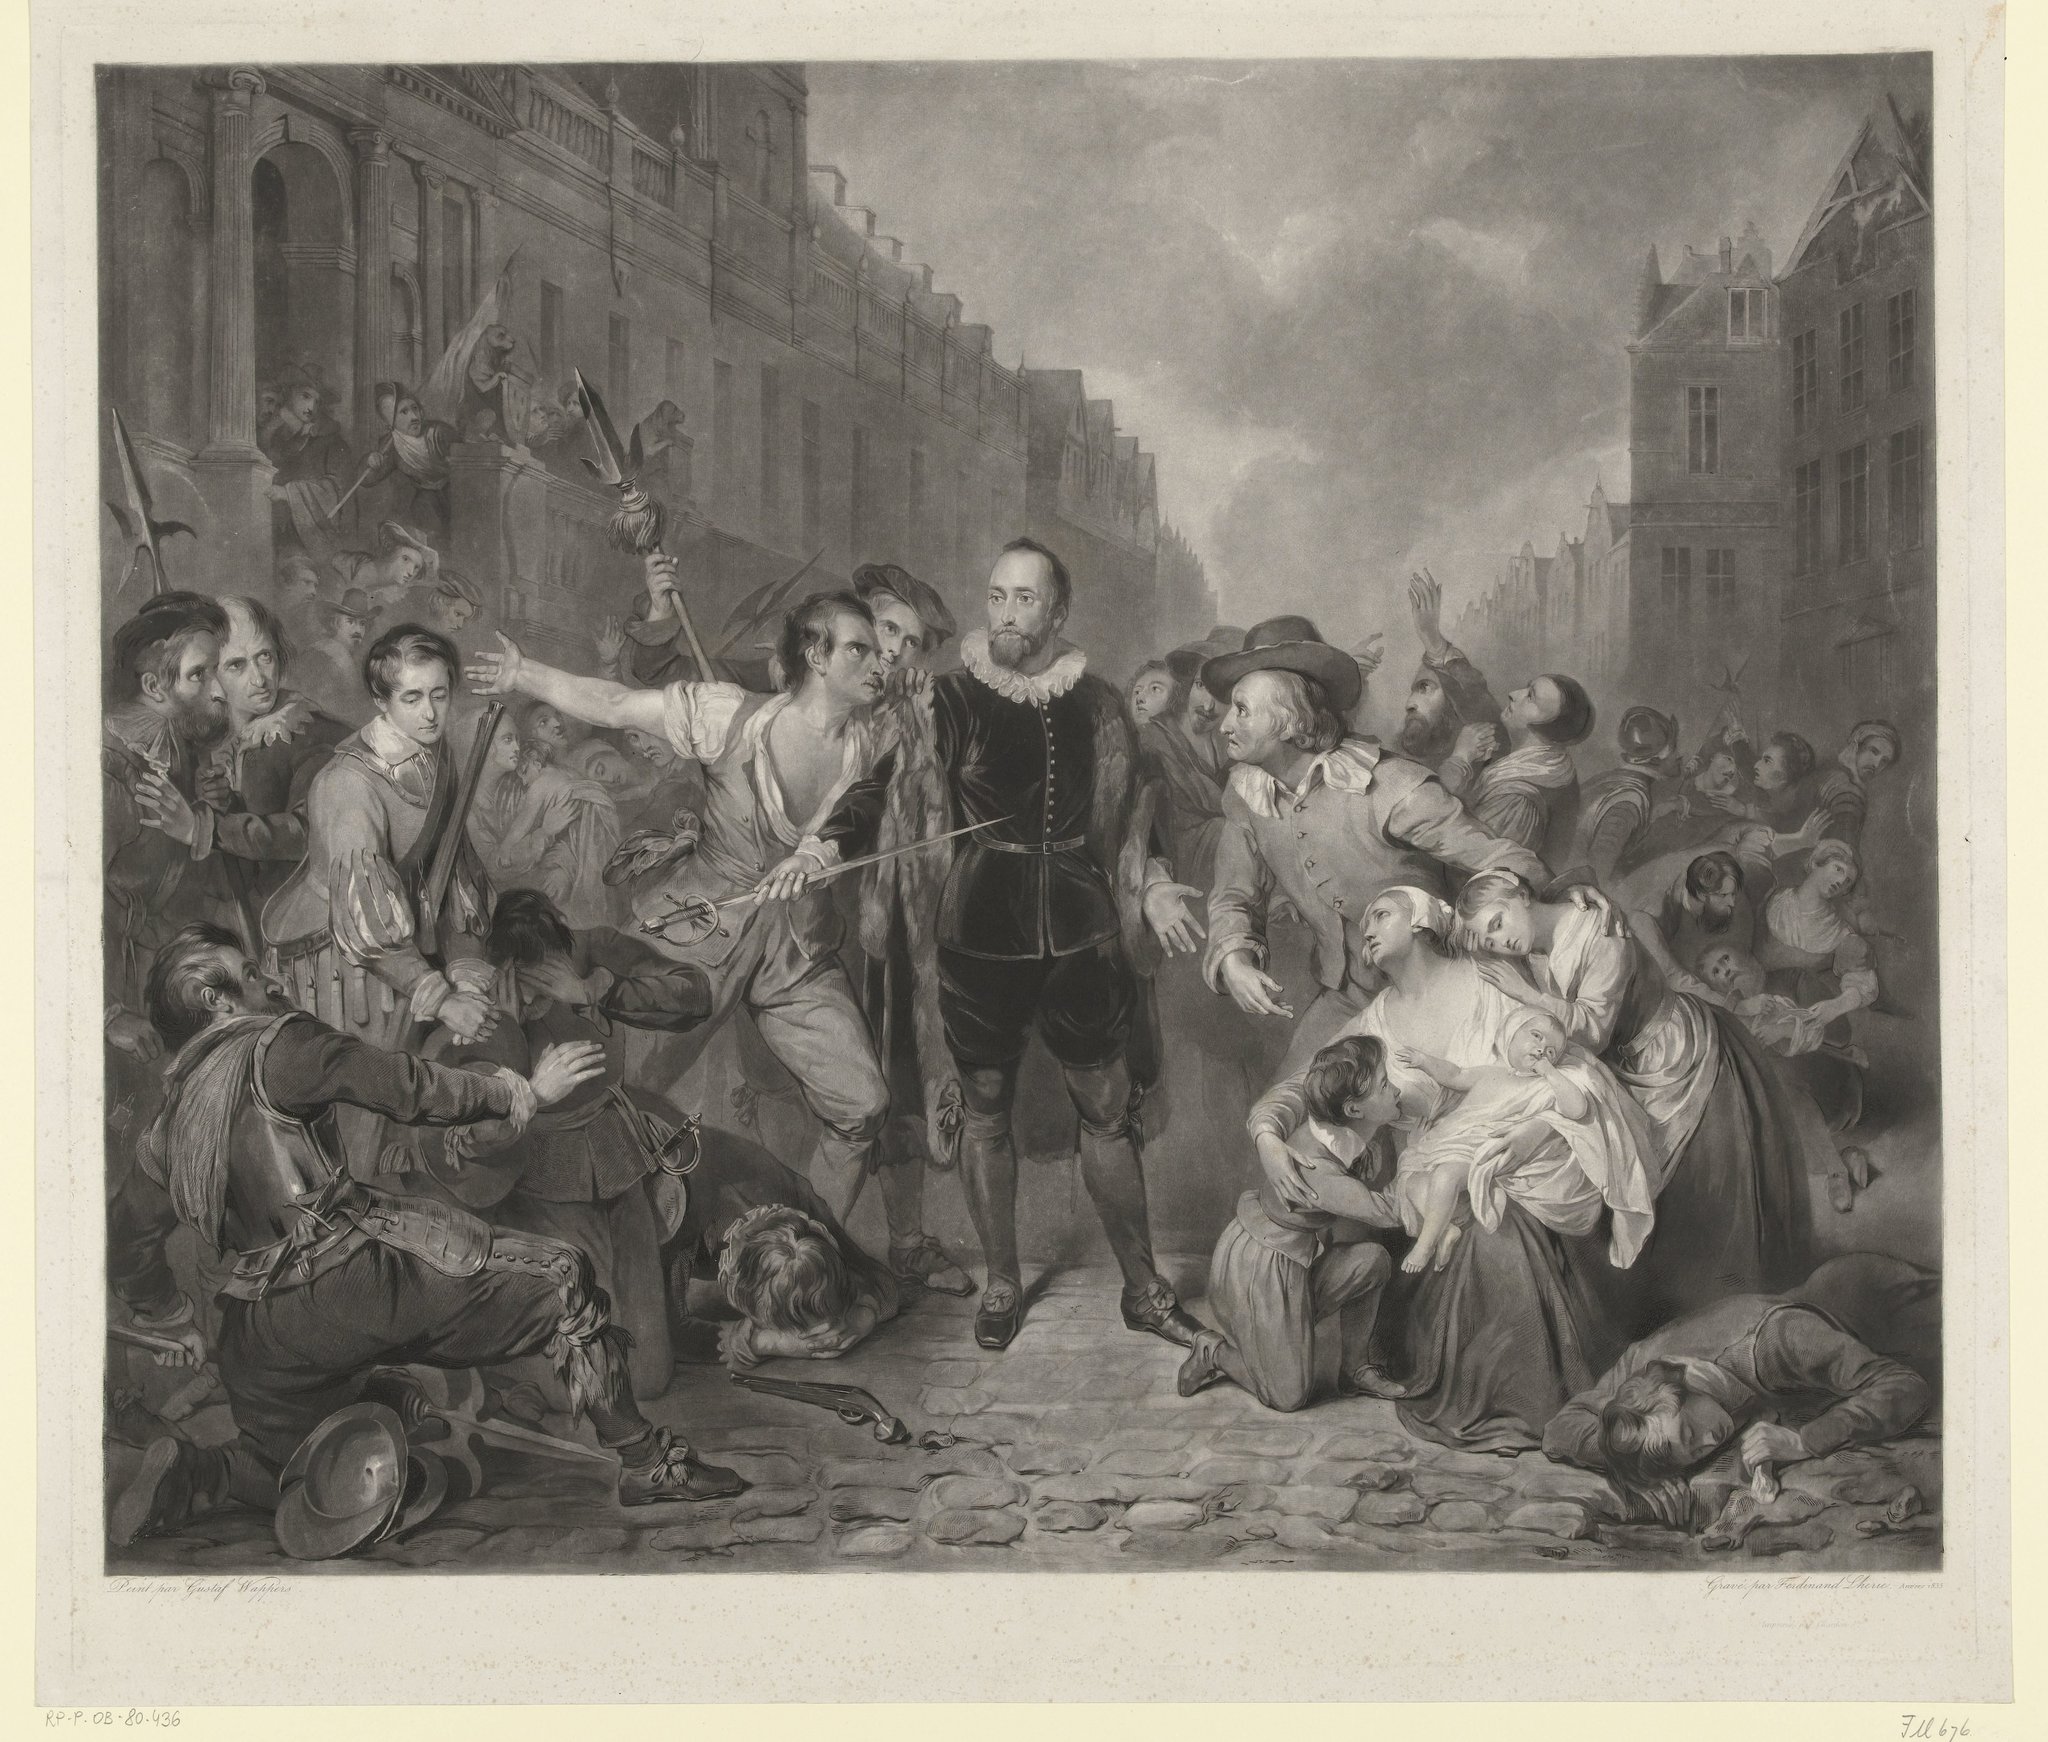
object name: history print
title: De zelfopoffering van burgemeester Pieter van der Werff, 1574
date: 1835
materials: paper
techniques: etching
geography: antwerp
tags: mayor, mayor, burgomaster, historical persons, street (+ city(-scape) with figures, staffage), leiden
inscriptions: date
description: De zelfopoffering van burgemeester Pieter van der Werff, tijdens het beleg van Leiden, september 1574. Van der Werff staande in de Breestraat voor het stadhuis straat tussen woedende Leidenaren en biedt hen zijn zwaard en lichaam aan.